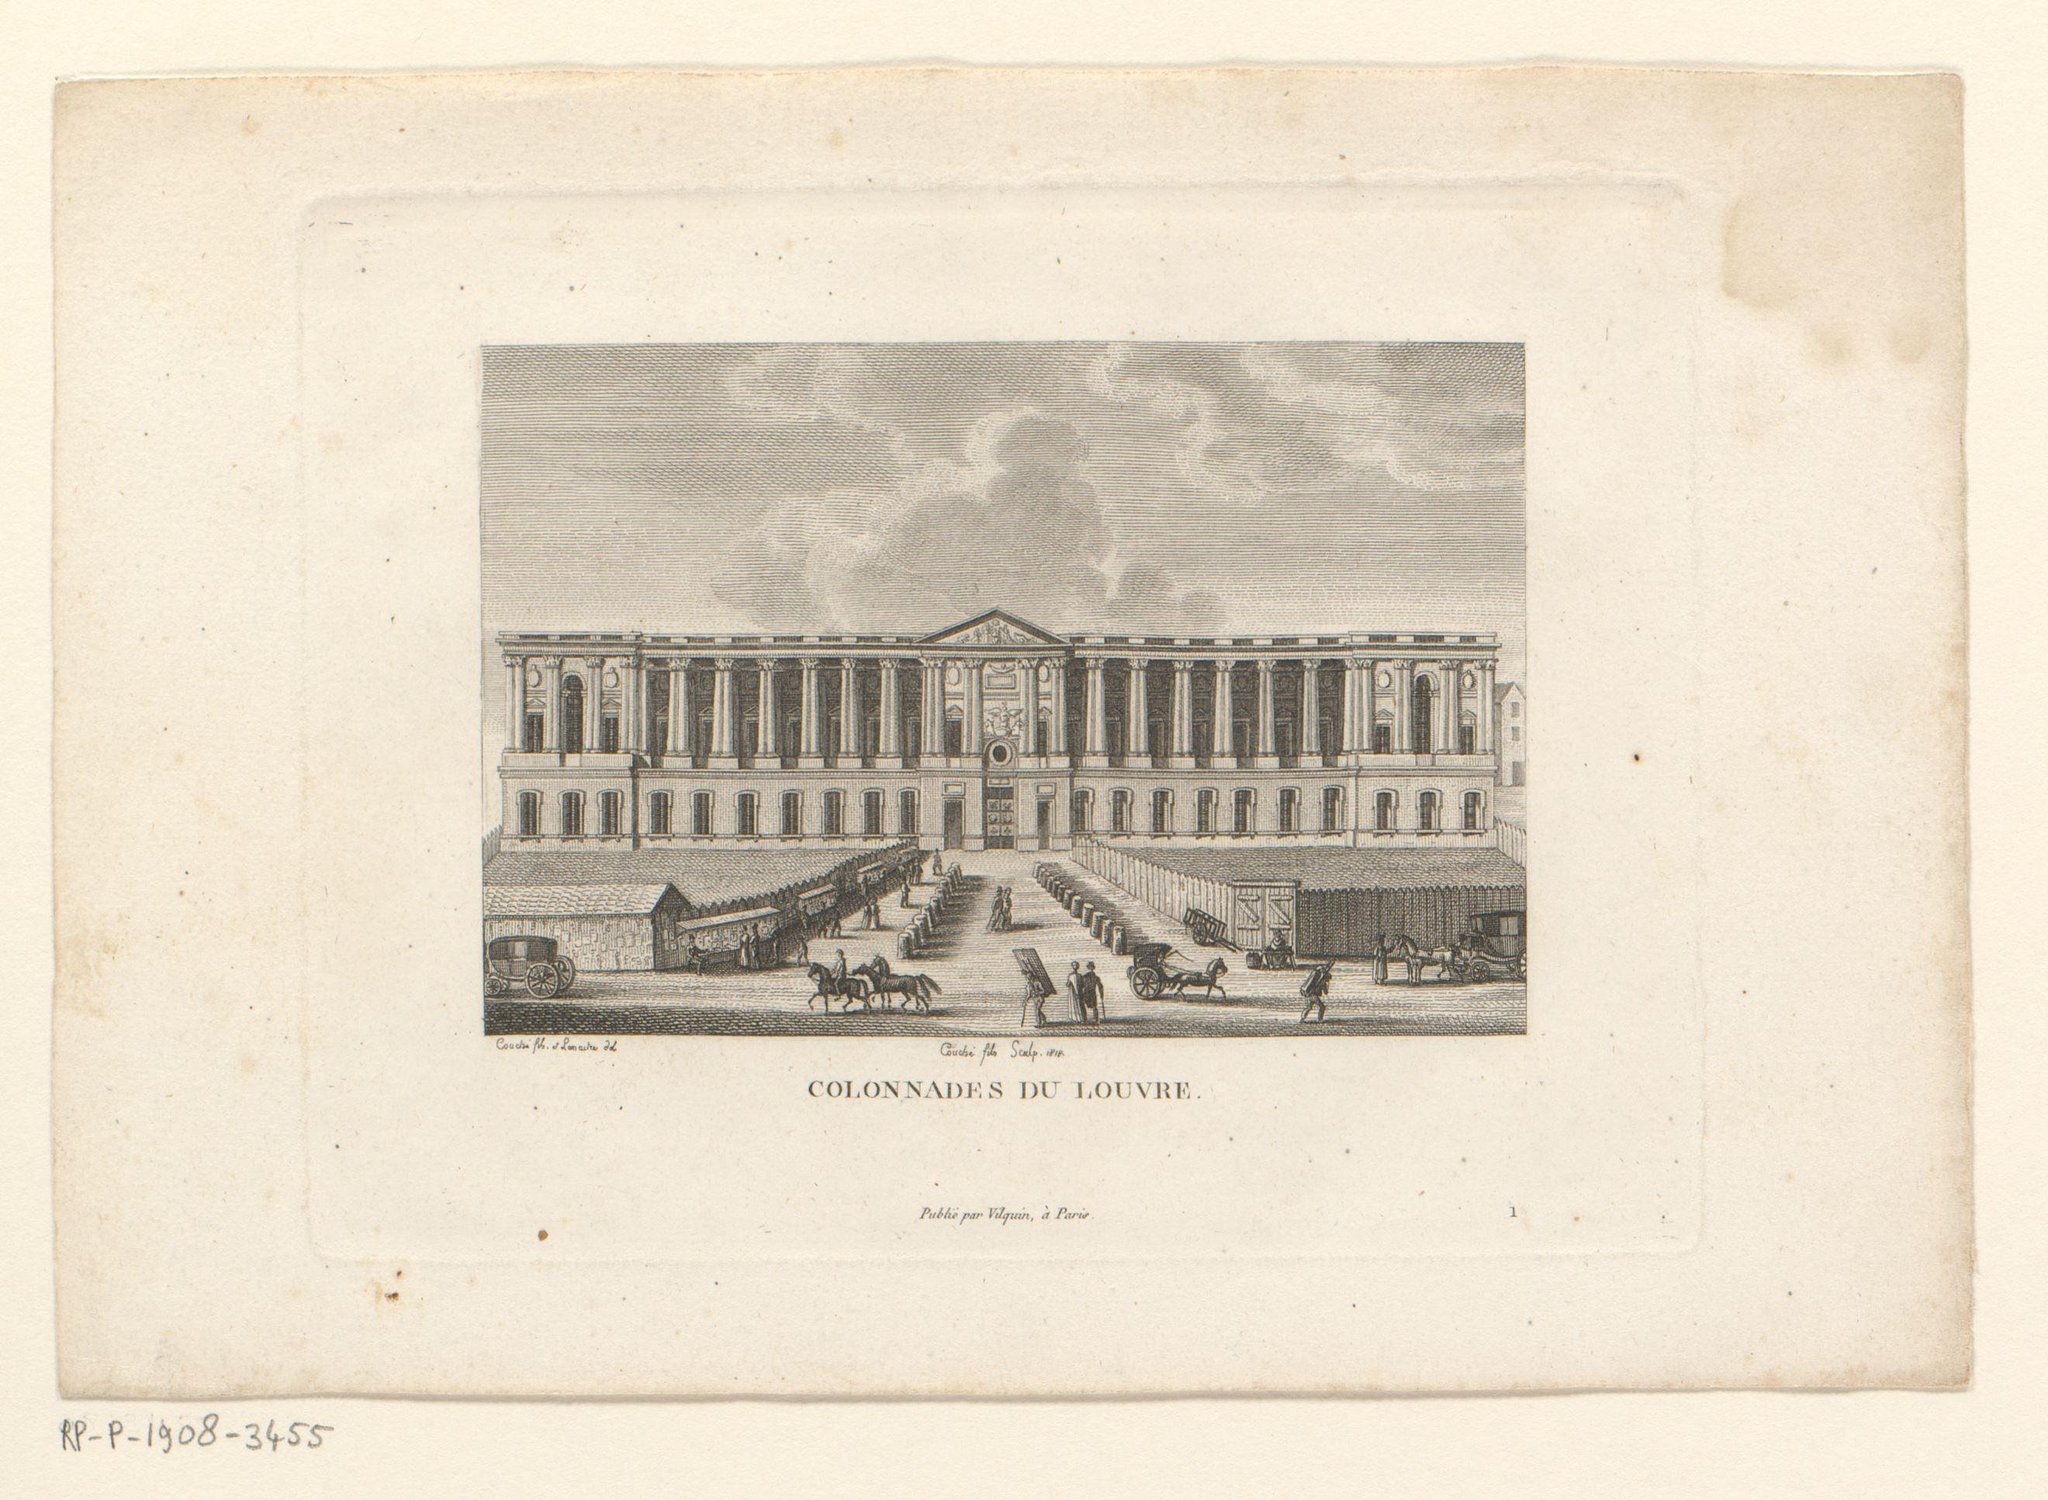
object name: print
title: Gezicht op het Palais du Louvre te Parijs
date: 1818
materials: paper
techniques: etching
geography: paris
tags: city-view in general; 'veduta', palace, paris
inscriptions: collector's mark: Lugt 2228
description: Maakt deel uit van een serie met 60 platen van monumenten, kathedralen en paleizen in Parijs.